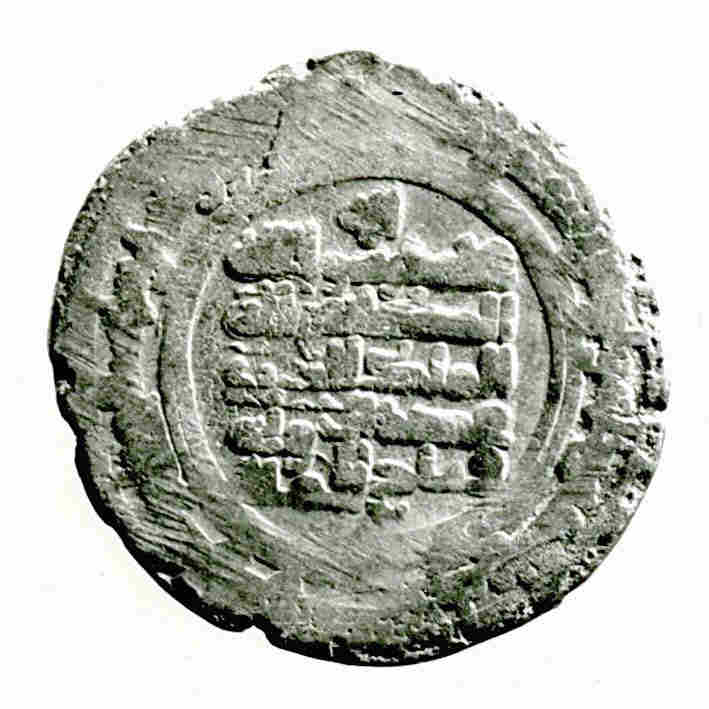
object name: coin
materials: silver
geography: amul